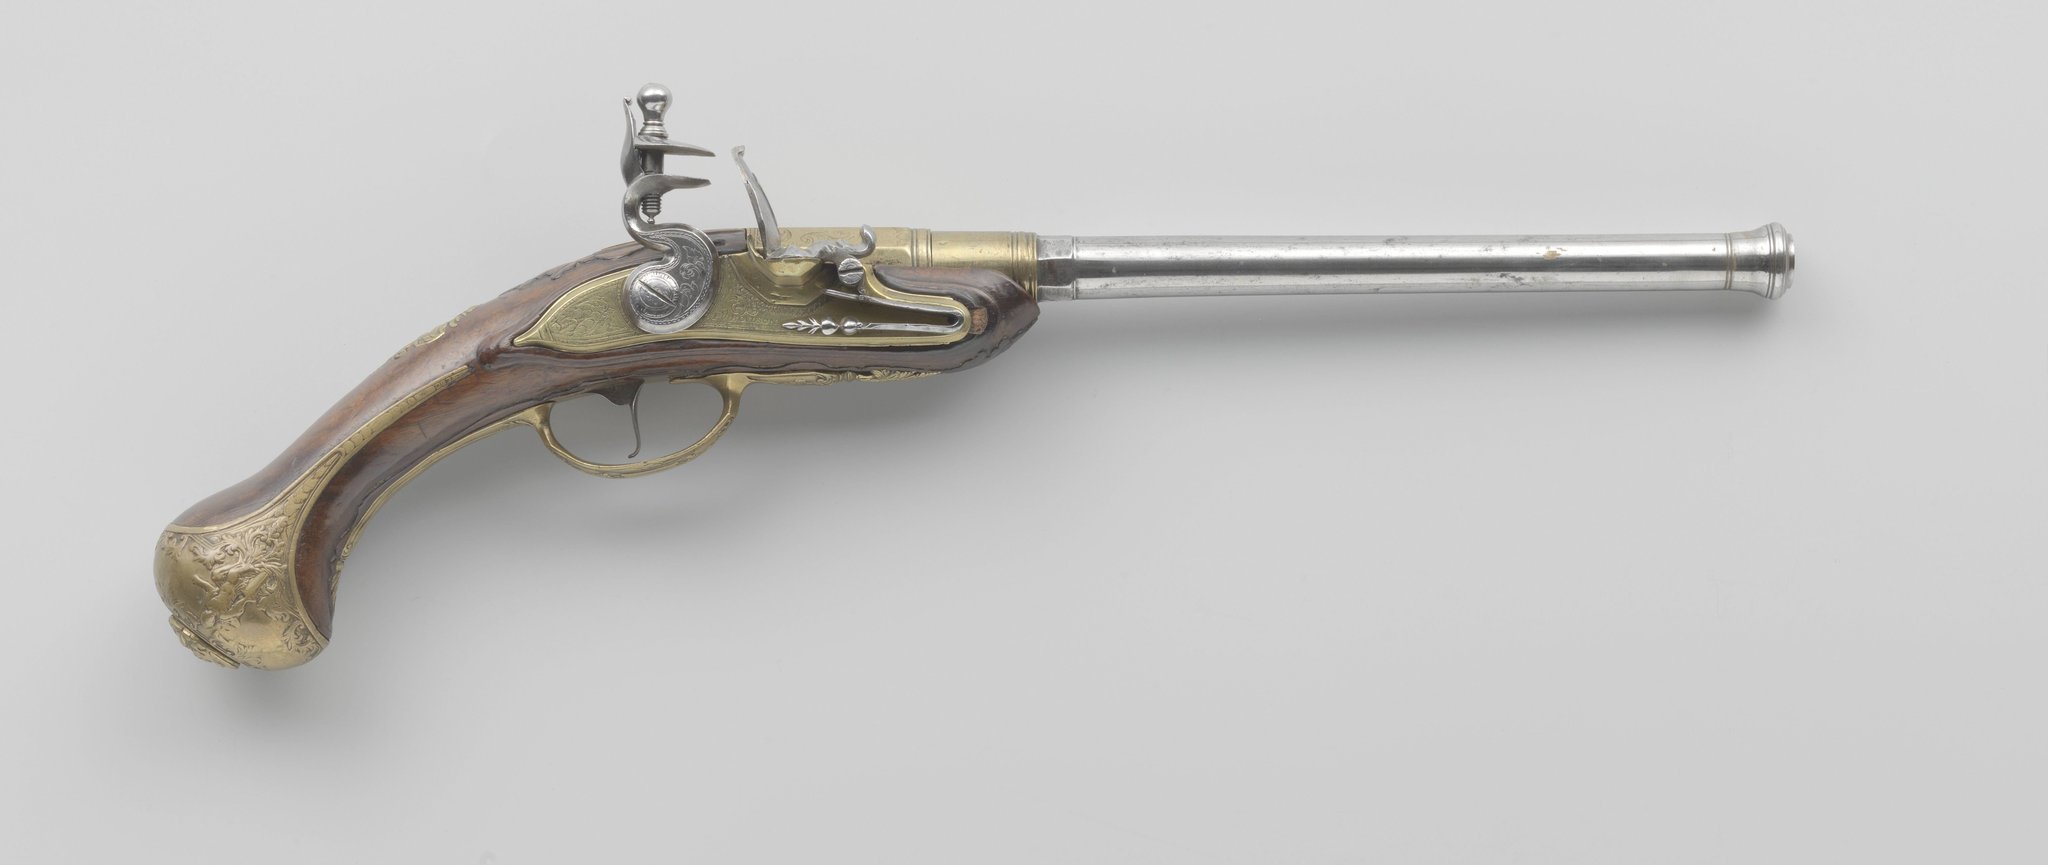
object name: pistol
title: Achterlaad vuursteenpistool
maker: p. boudson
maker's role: geweermaker, pistoolmaker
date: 1705-1710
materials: brass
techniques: casting, metalworking, cutting, embroidery, engraving, gilding, relief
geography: liège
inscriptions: signature: ‘P BOVDSON’